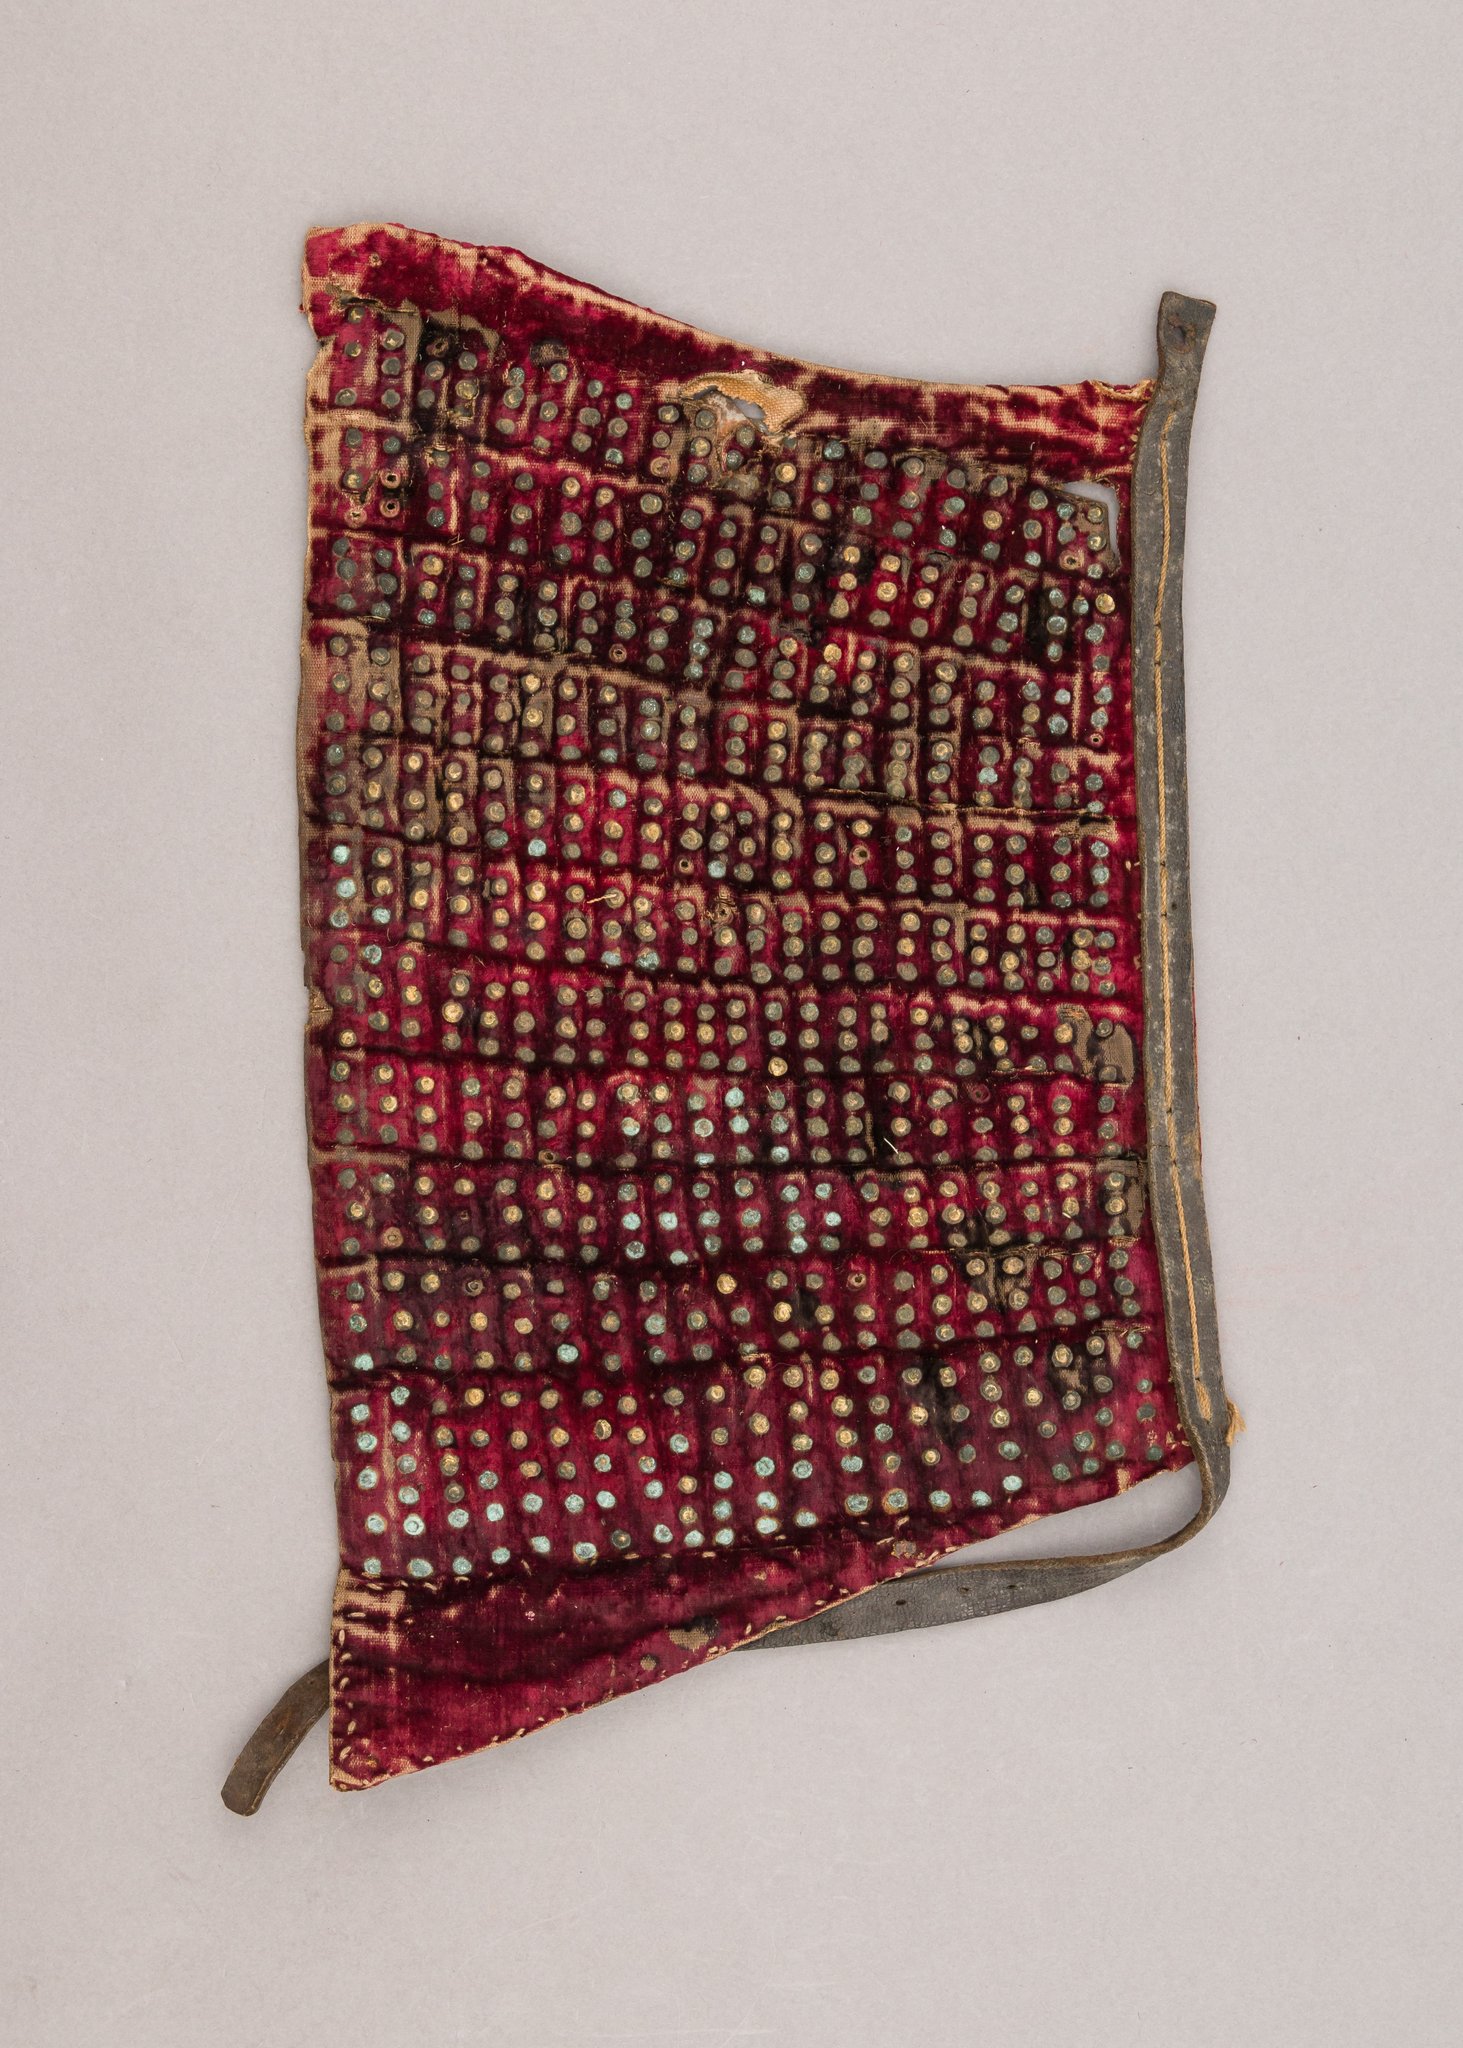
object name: pair of brigandine tasset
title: Pair of Brigandine Tassets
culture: italian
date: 1500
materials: gilt copper, leather, metal, textile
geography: italy